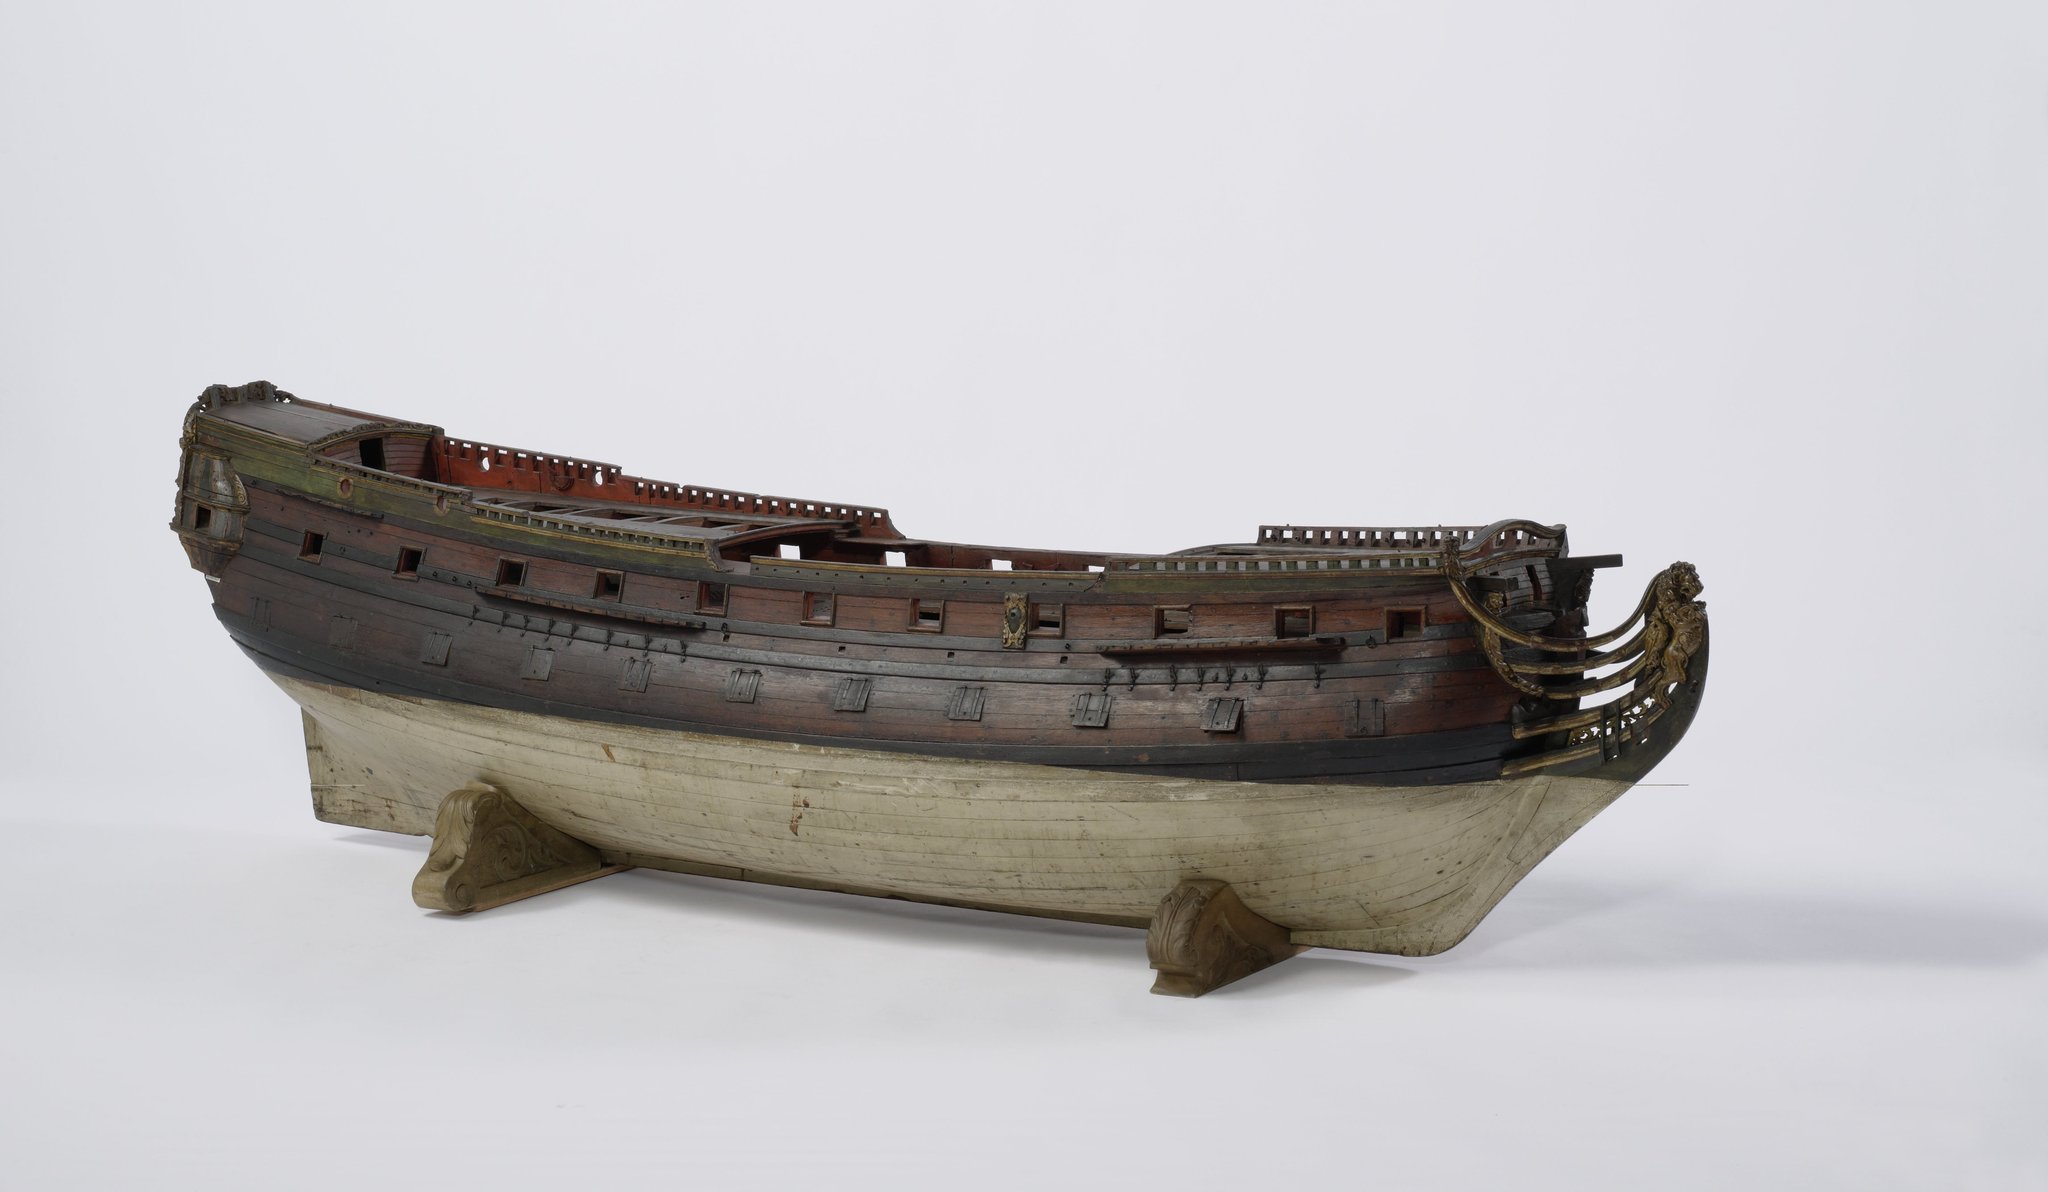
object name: hull model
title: Model of a Ship of War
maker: Anonymous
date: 1500-1900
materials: wood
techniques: polychromy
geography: netherlands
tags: zwijndrecht (schip)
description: Gepolychromeerd model van een oorlogsschip.